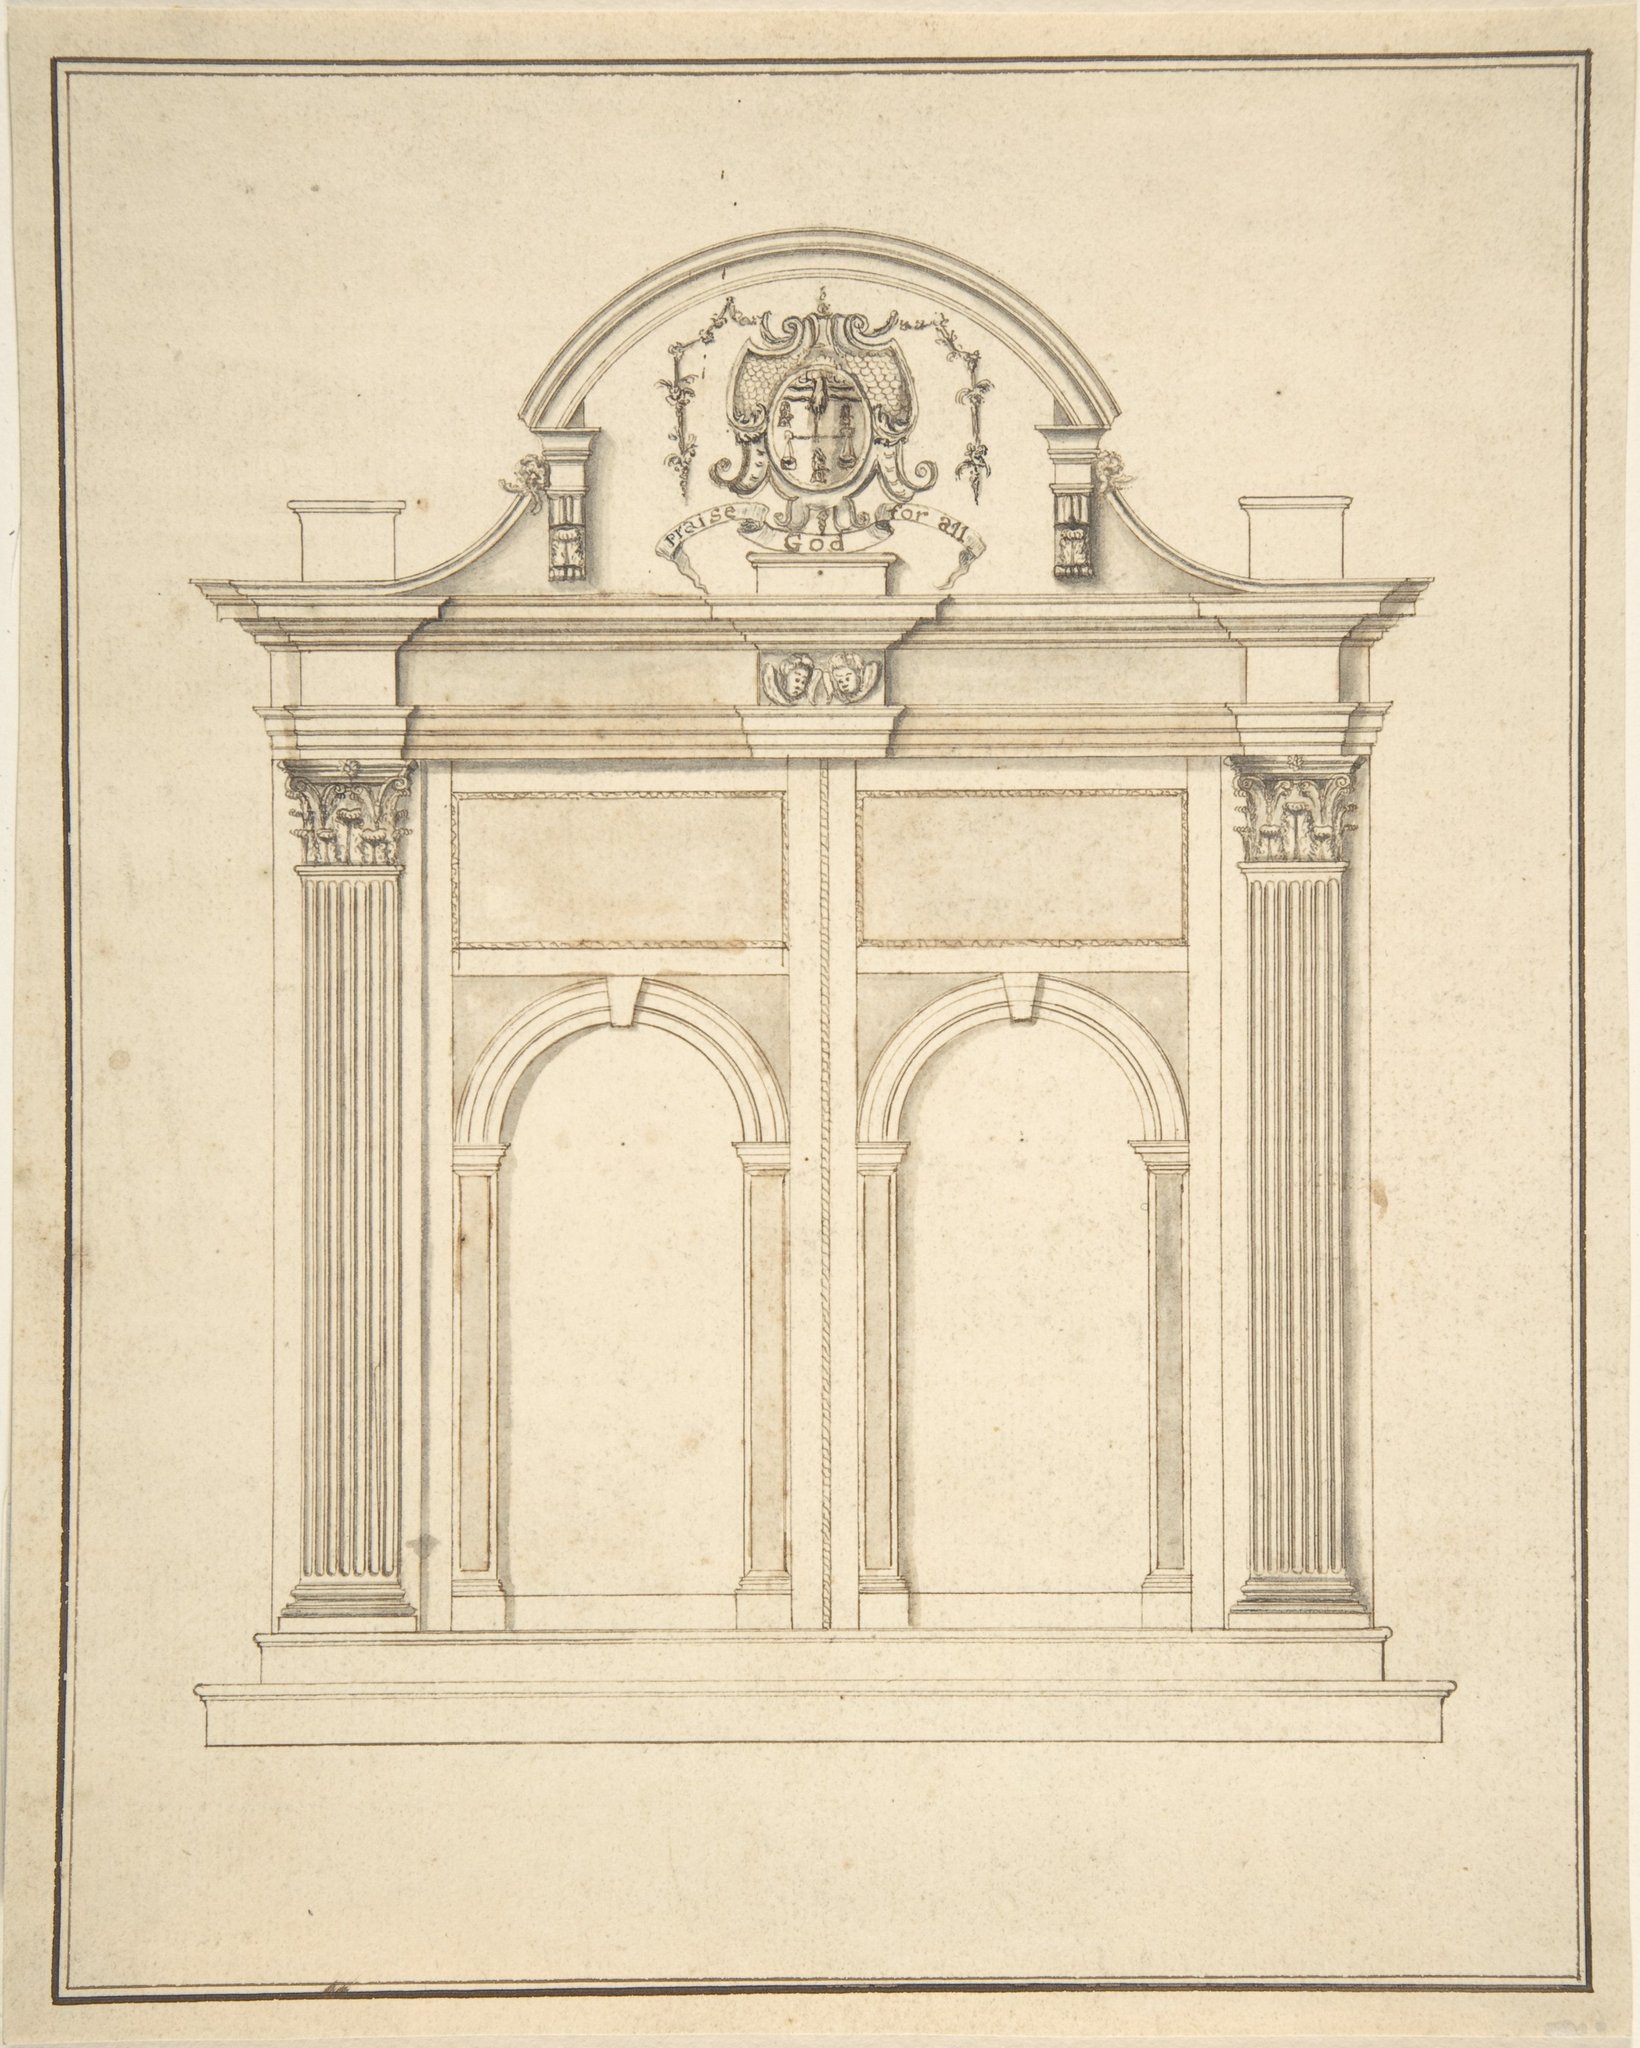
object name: drawing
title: Design for a doorway for a chapel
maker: anonymous, british, 17th century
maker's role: artist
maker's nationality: british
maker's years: 1600-1700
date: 1601-1700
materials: ink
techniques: brush, pen, wash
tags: architecture